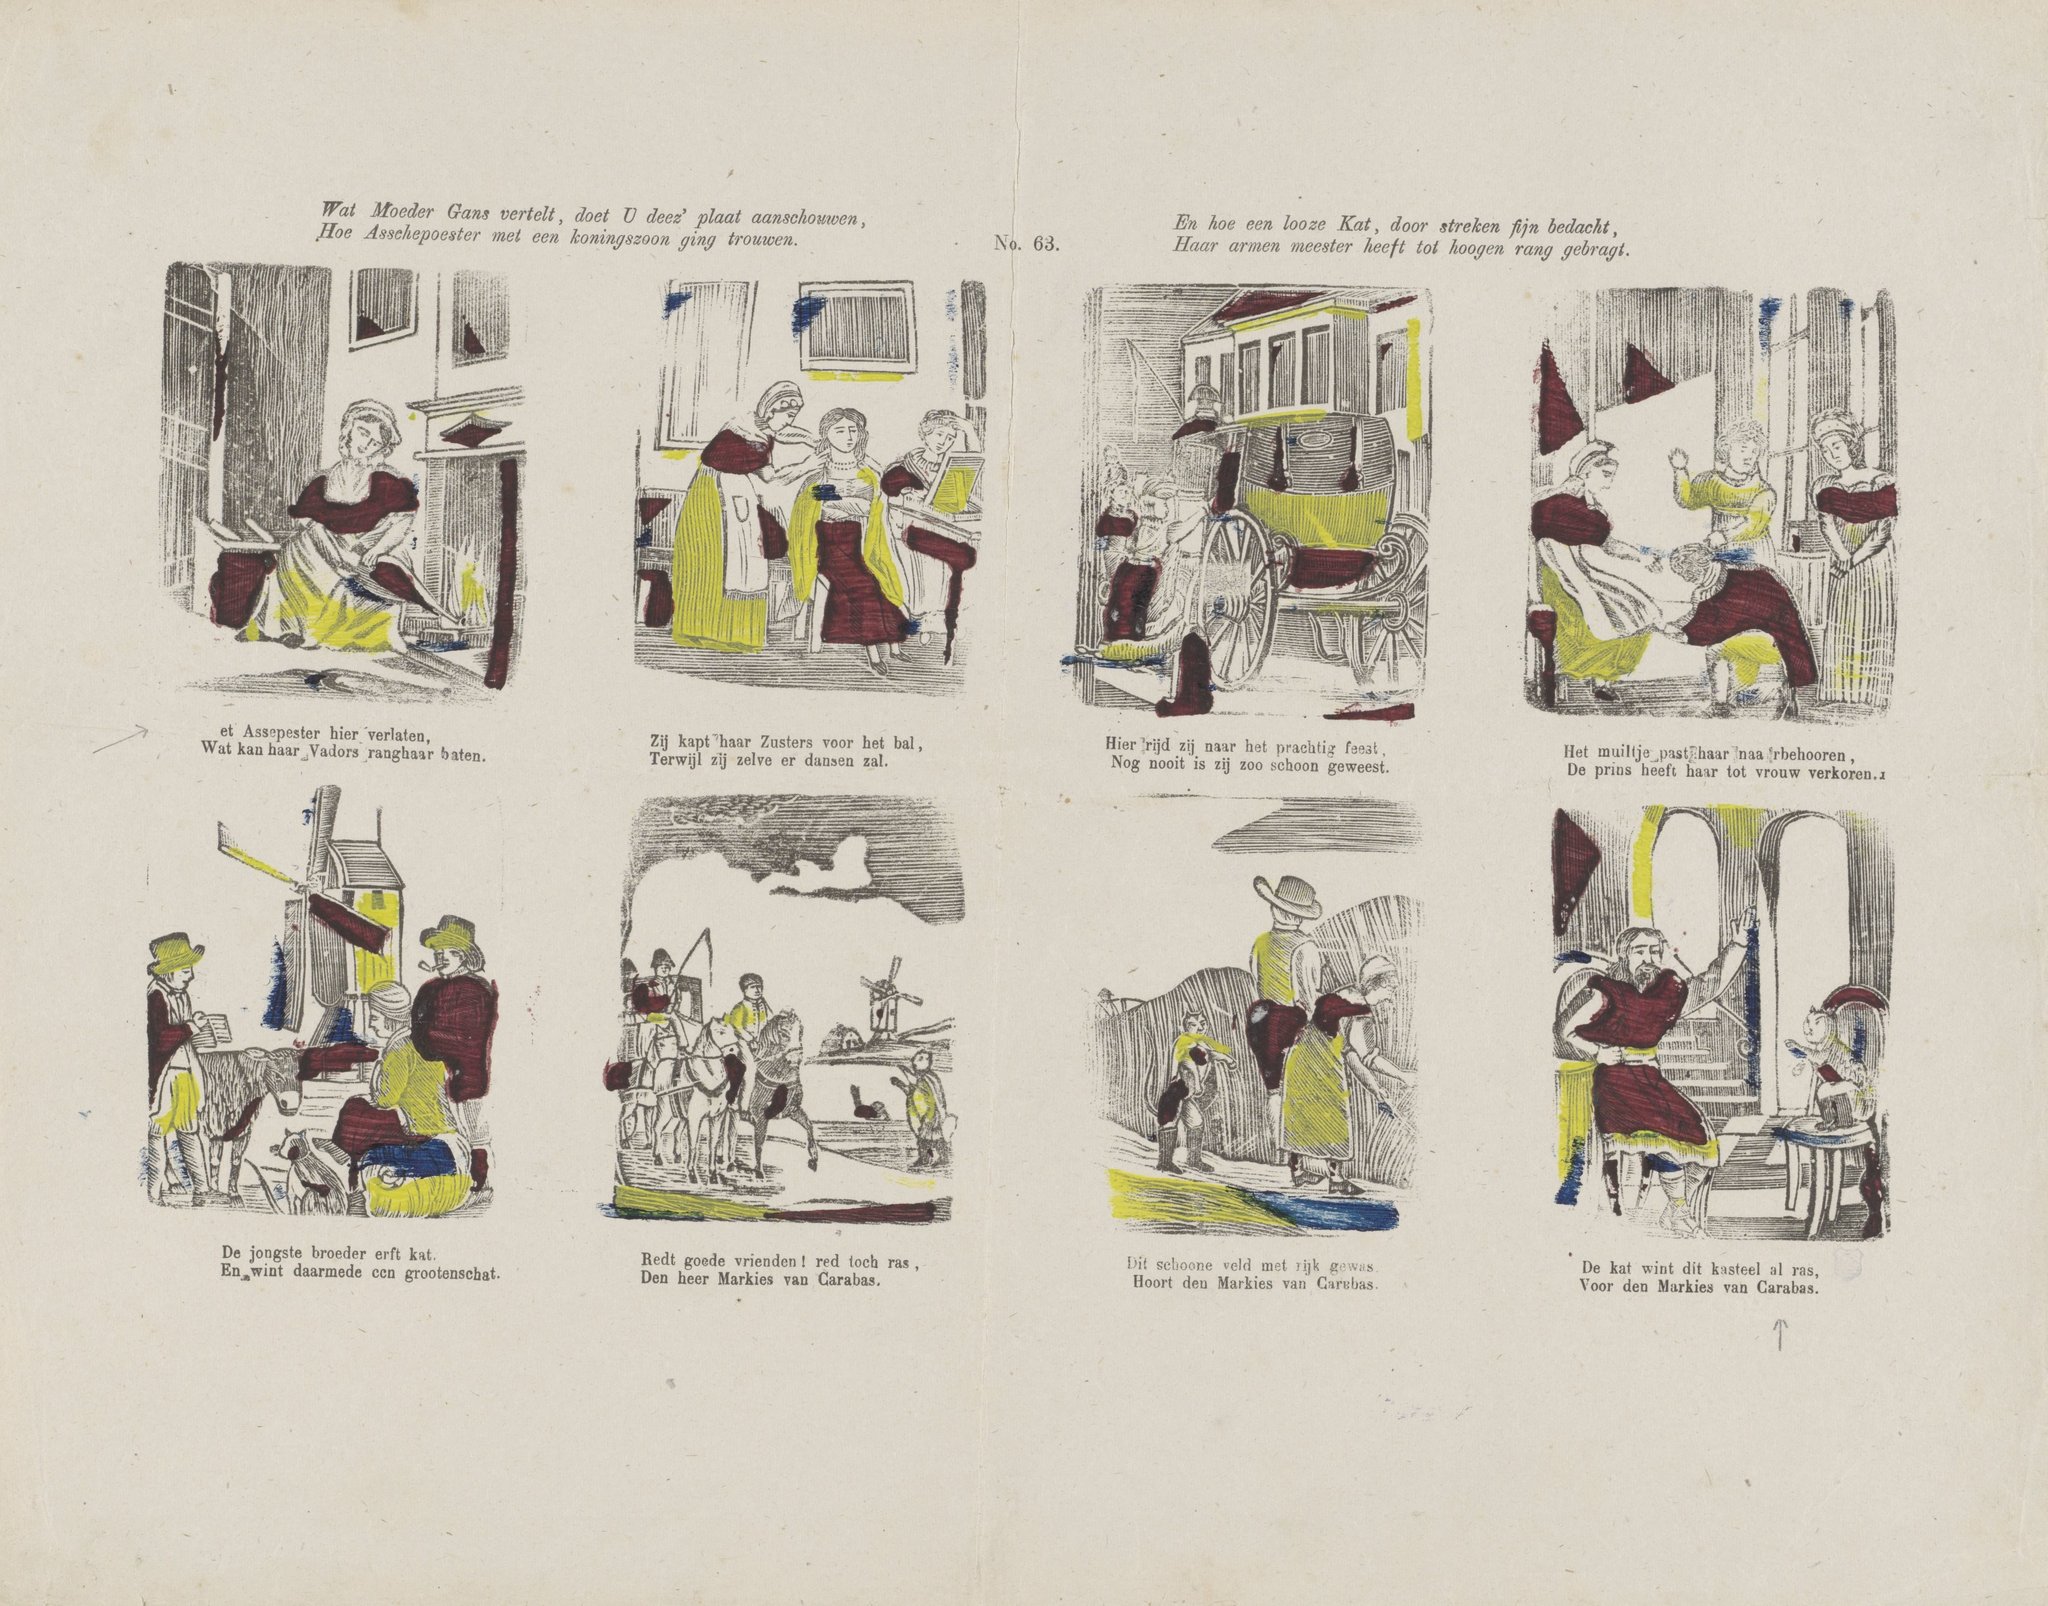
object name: popular print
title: Wat Moeder Gans vertelt, doet u deez' plaat aanschouwen, / Hoe Asschepoester met een koningszoon ging trouwen. / En hoe een looze kat, door streken fijn bedacht, / Haar armen meester heeft tot hogen rang gebragt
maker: Anonymous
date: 1848-1881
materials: paper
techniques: colour, letterpress printing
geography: den bosch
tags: tales and fairy tales (with title), tales and fairy tales: puss in boots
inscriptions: collector's mark: Lugt 2760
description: Blad met 8 voorstellingen uit de sprookjes van Assepoester en de gelaarsde kat. Onder elke afbeelding een tweeregelig vers. Genummerd midden boven: No. 63.